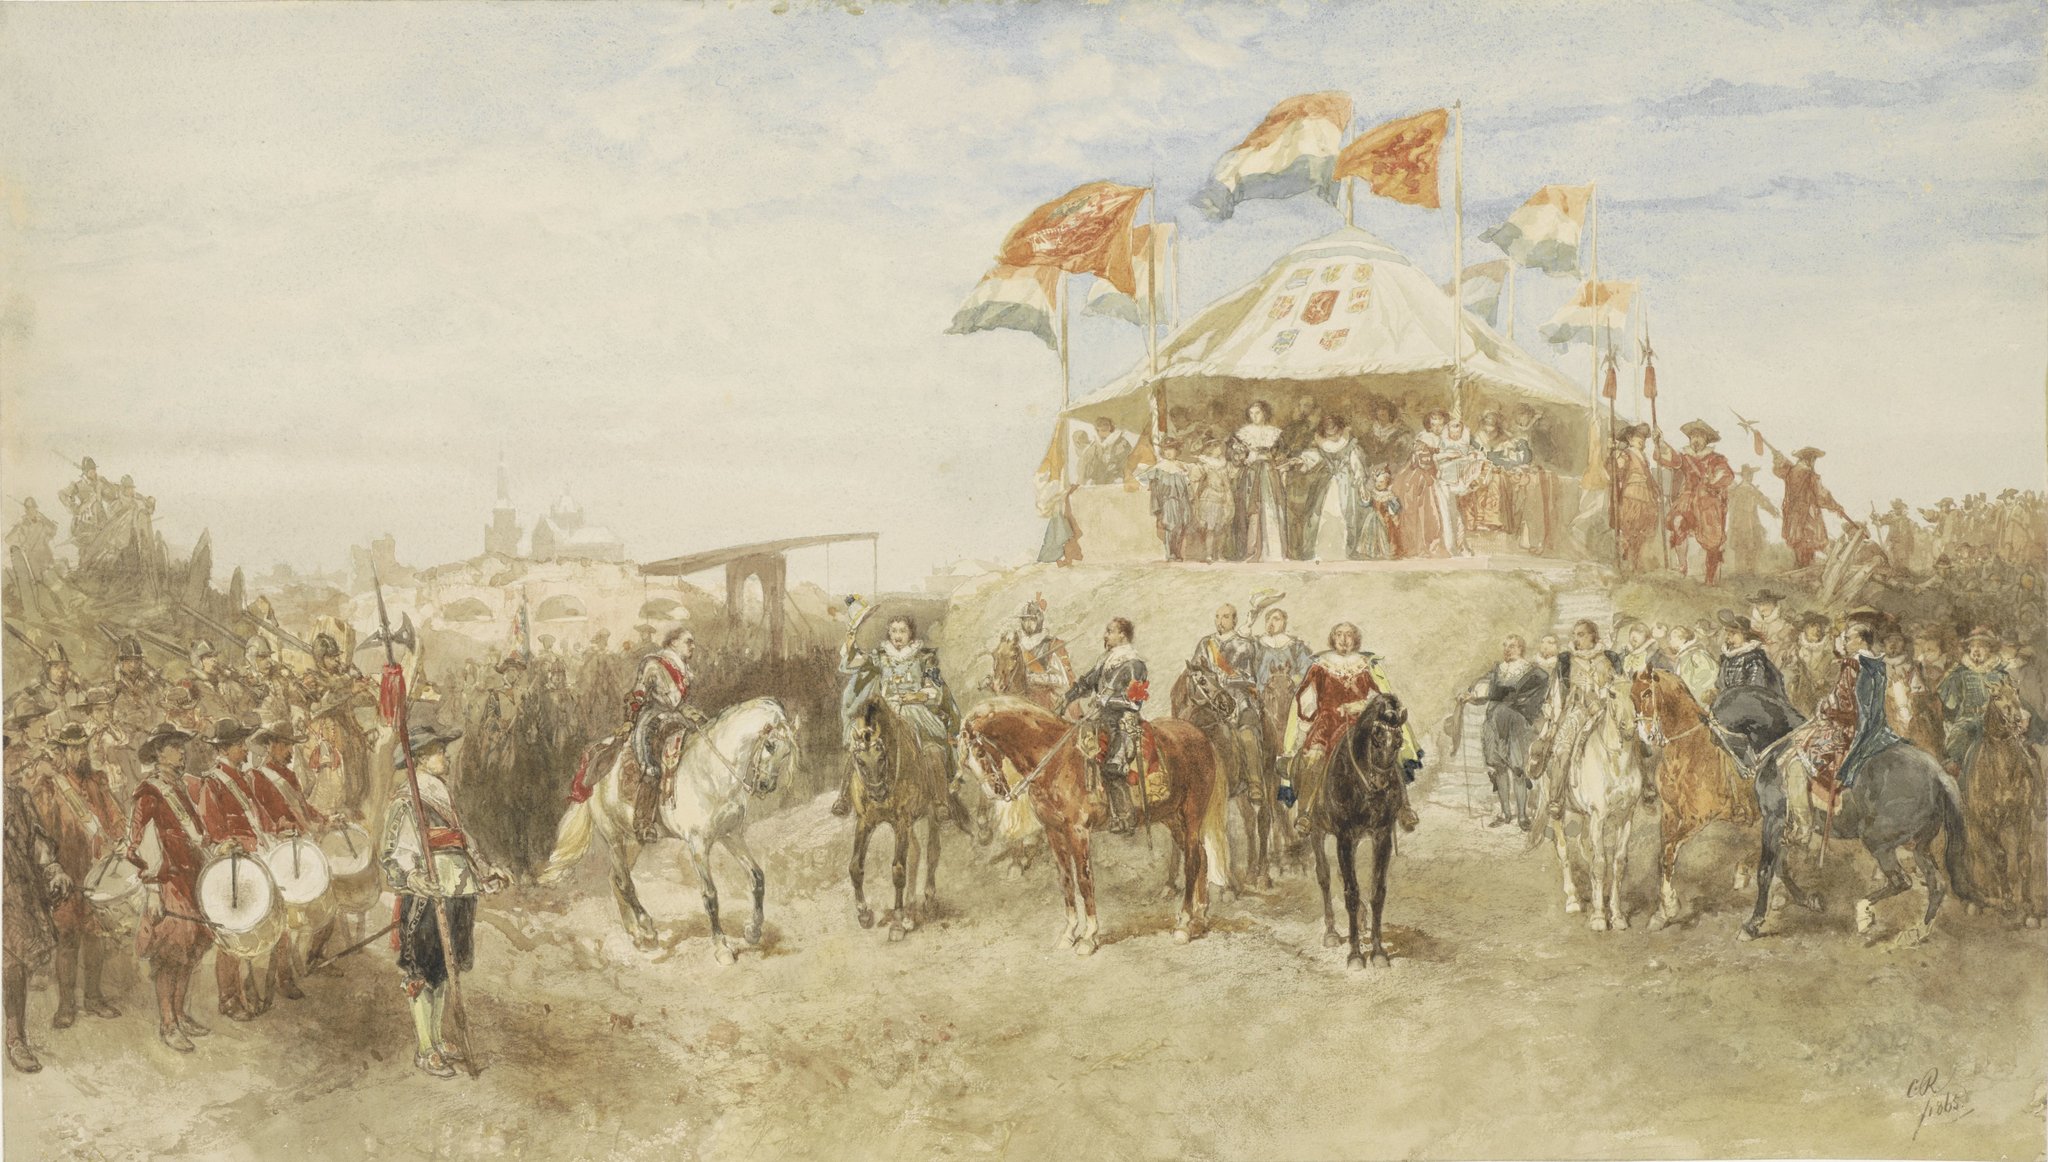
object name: watercolor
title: Het vertrek van het Spaanse garnizoen uit Den Bosch na de overgave aan Frederik Hendrik in 1629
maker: charles rochussen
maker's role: draughtsman, painter, print maker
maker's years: 1814-1894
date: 1865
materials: paper, pencil, watercolor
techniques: brush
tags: delft, the hague, frederick henry (prince of orange), historical persons, capture of city (after the siege), retreat of the defeated, historical events and situations, den bosch